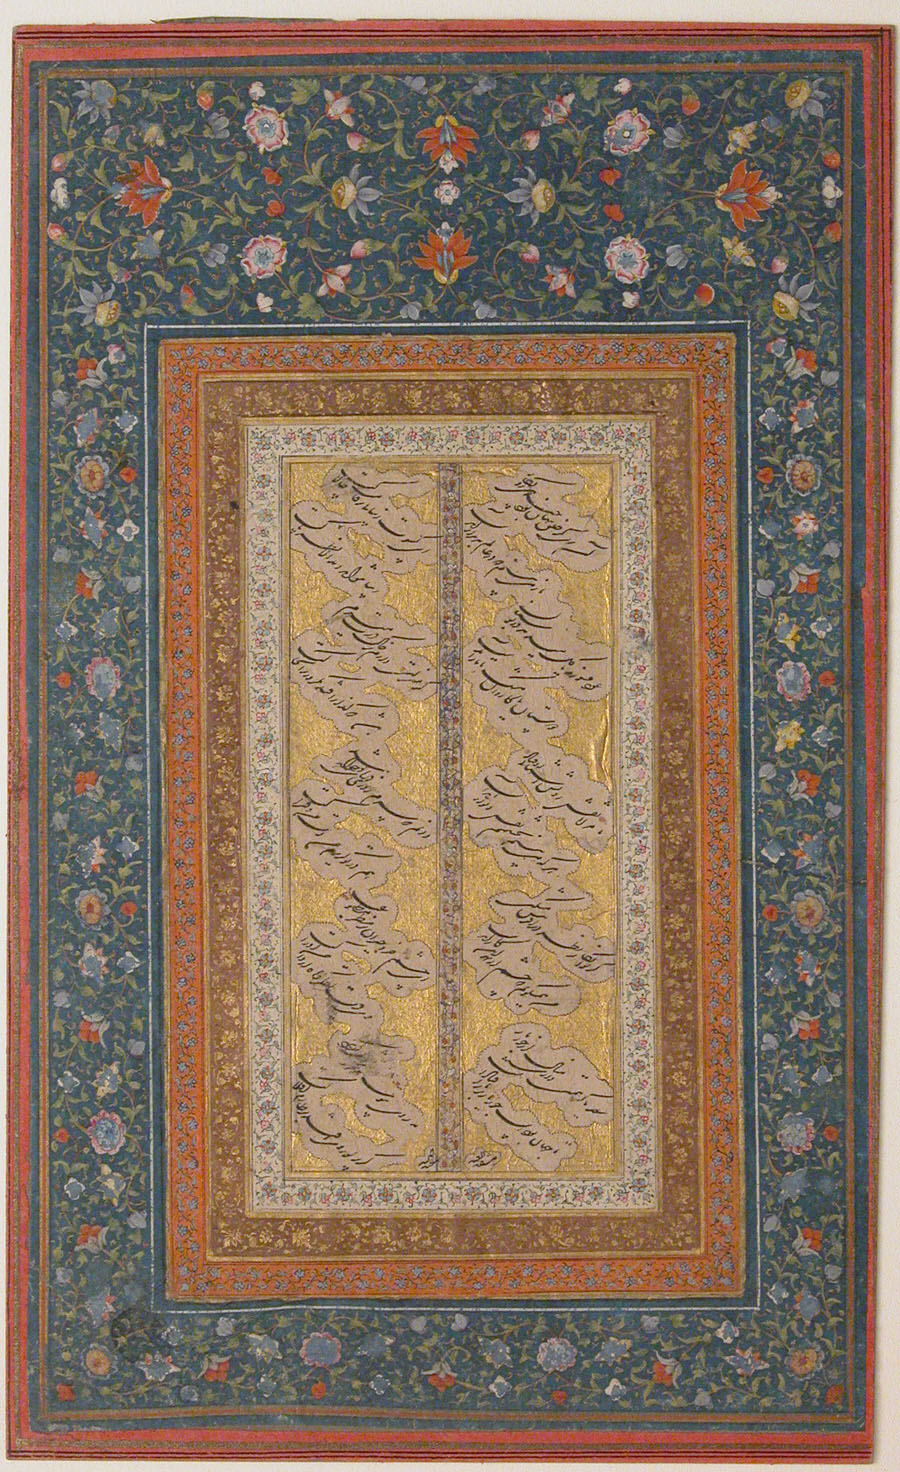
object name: non illustrated album leaf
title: Page of Calligraphy from the Kulliyat of Sa'di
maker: abd al-majid taleqani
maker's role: calligrapher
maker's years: 1712-1796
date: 1701-1800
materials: gold, ink, paper, watercolor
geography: iran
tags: poetry,persian,flowers,calligraphy